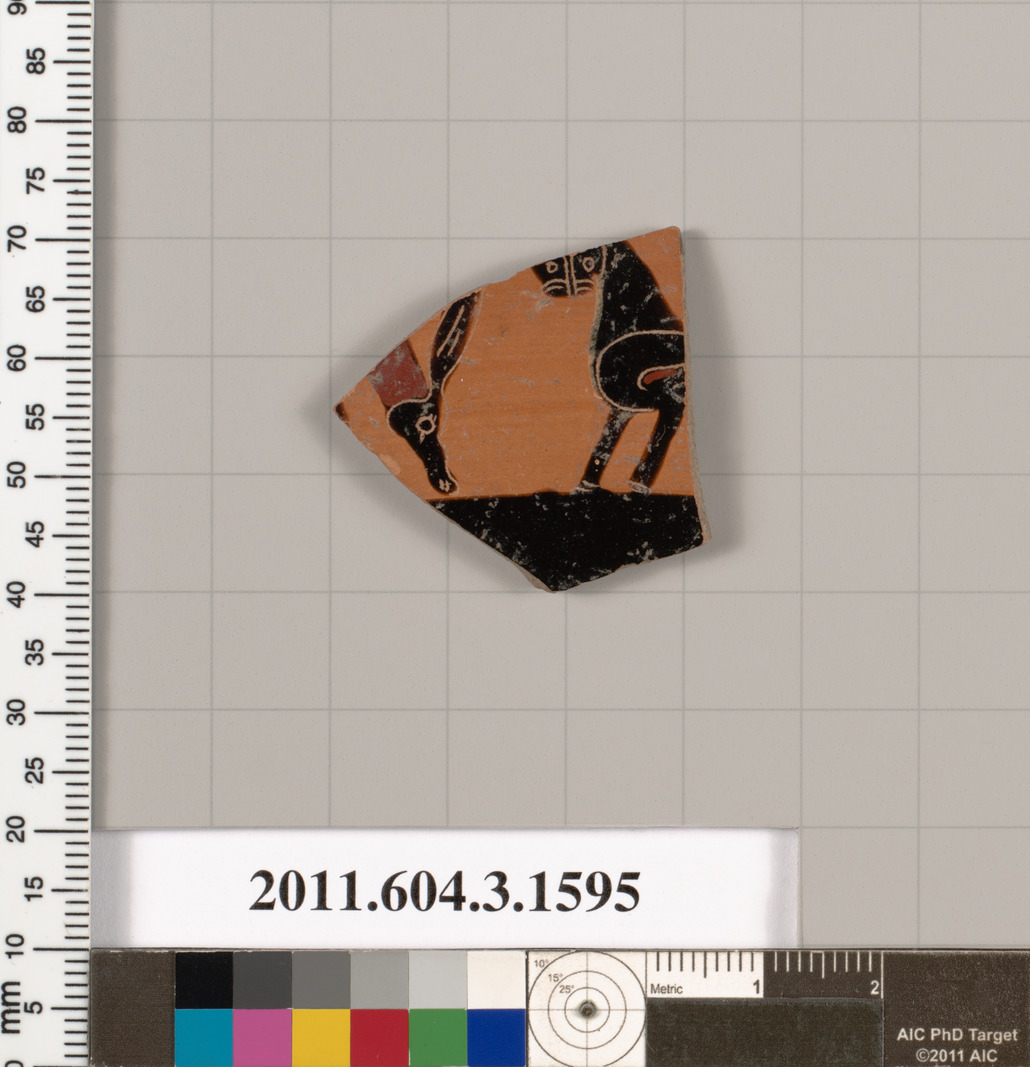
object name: kylix fragment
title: Terracotta fragment of a kylix: Band cup (drinking cup)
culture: greek, attic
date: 567-535 BCE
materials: terracotta